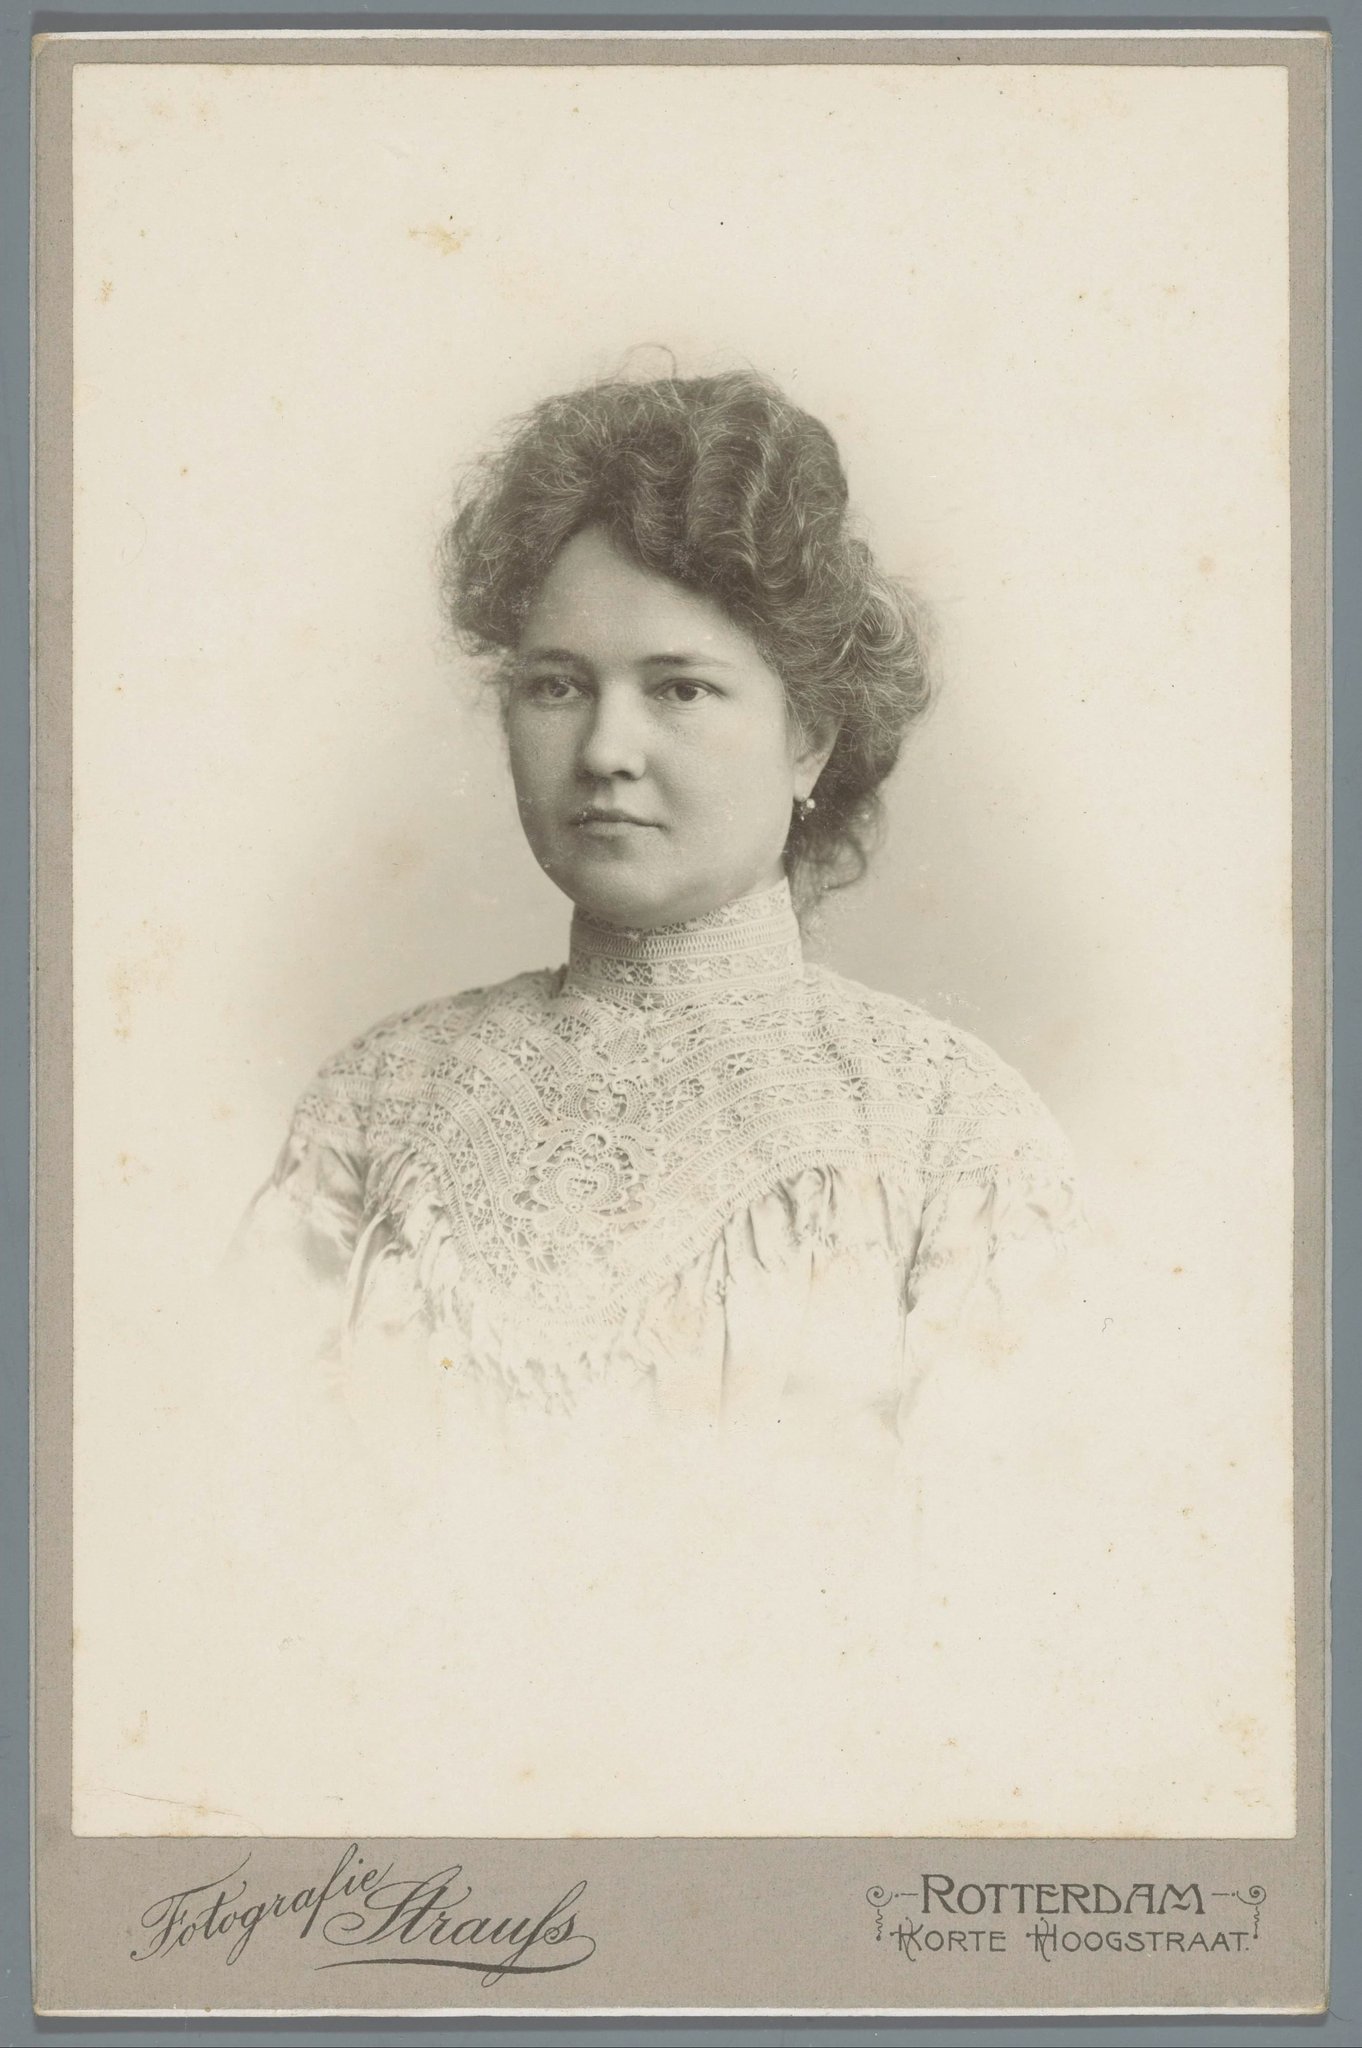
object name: cabinet photograph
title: Portret van een onbekende vrouw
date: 1900-1915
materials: cardboard, photographic support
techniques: gelatin silver print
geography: rotterdam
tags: adult woman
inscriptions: inscription: ‘Fotografie Strauss Rotterdam in het gebouw de Galerij Korte Hoogstraat (...) Vergrootingen in alle Formaten.’